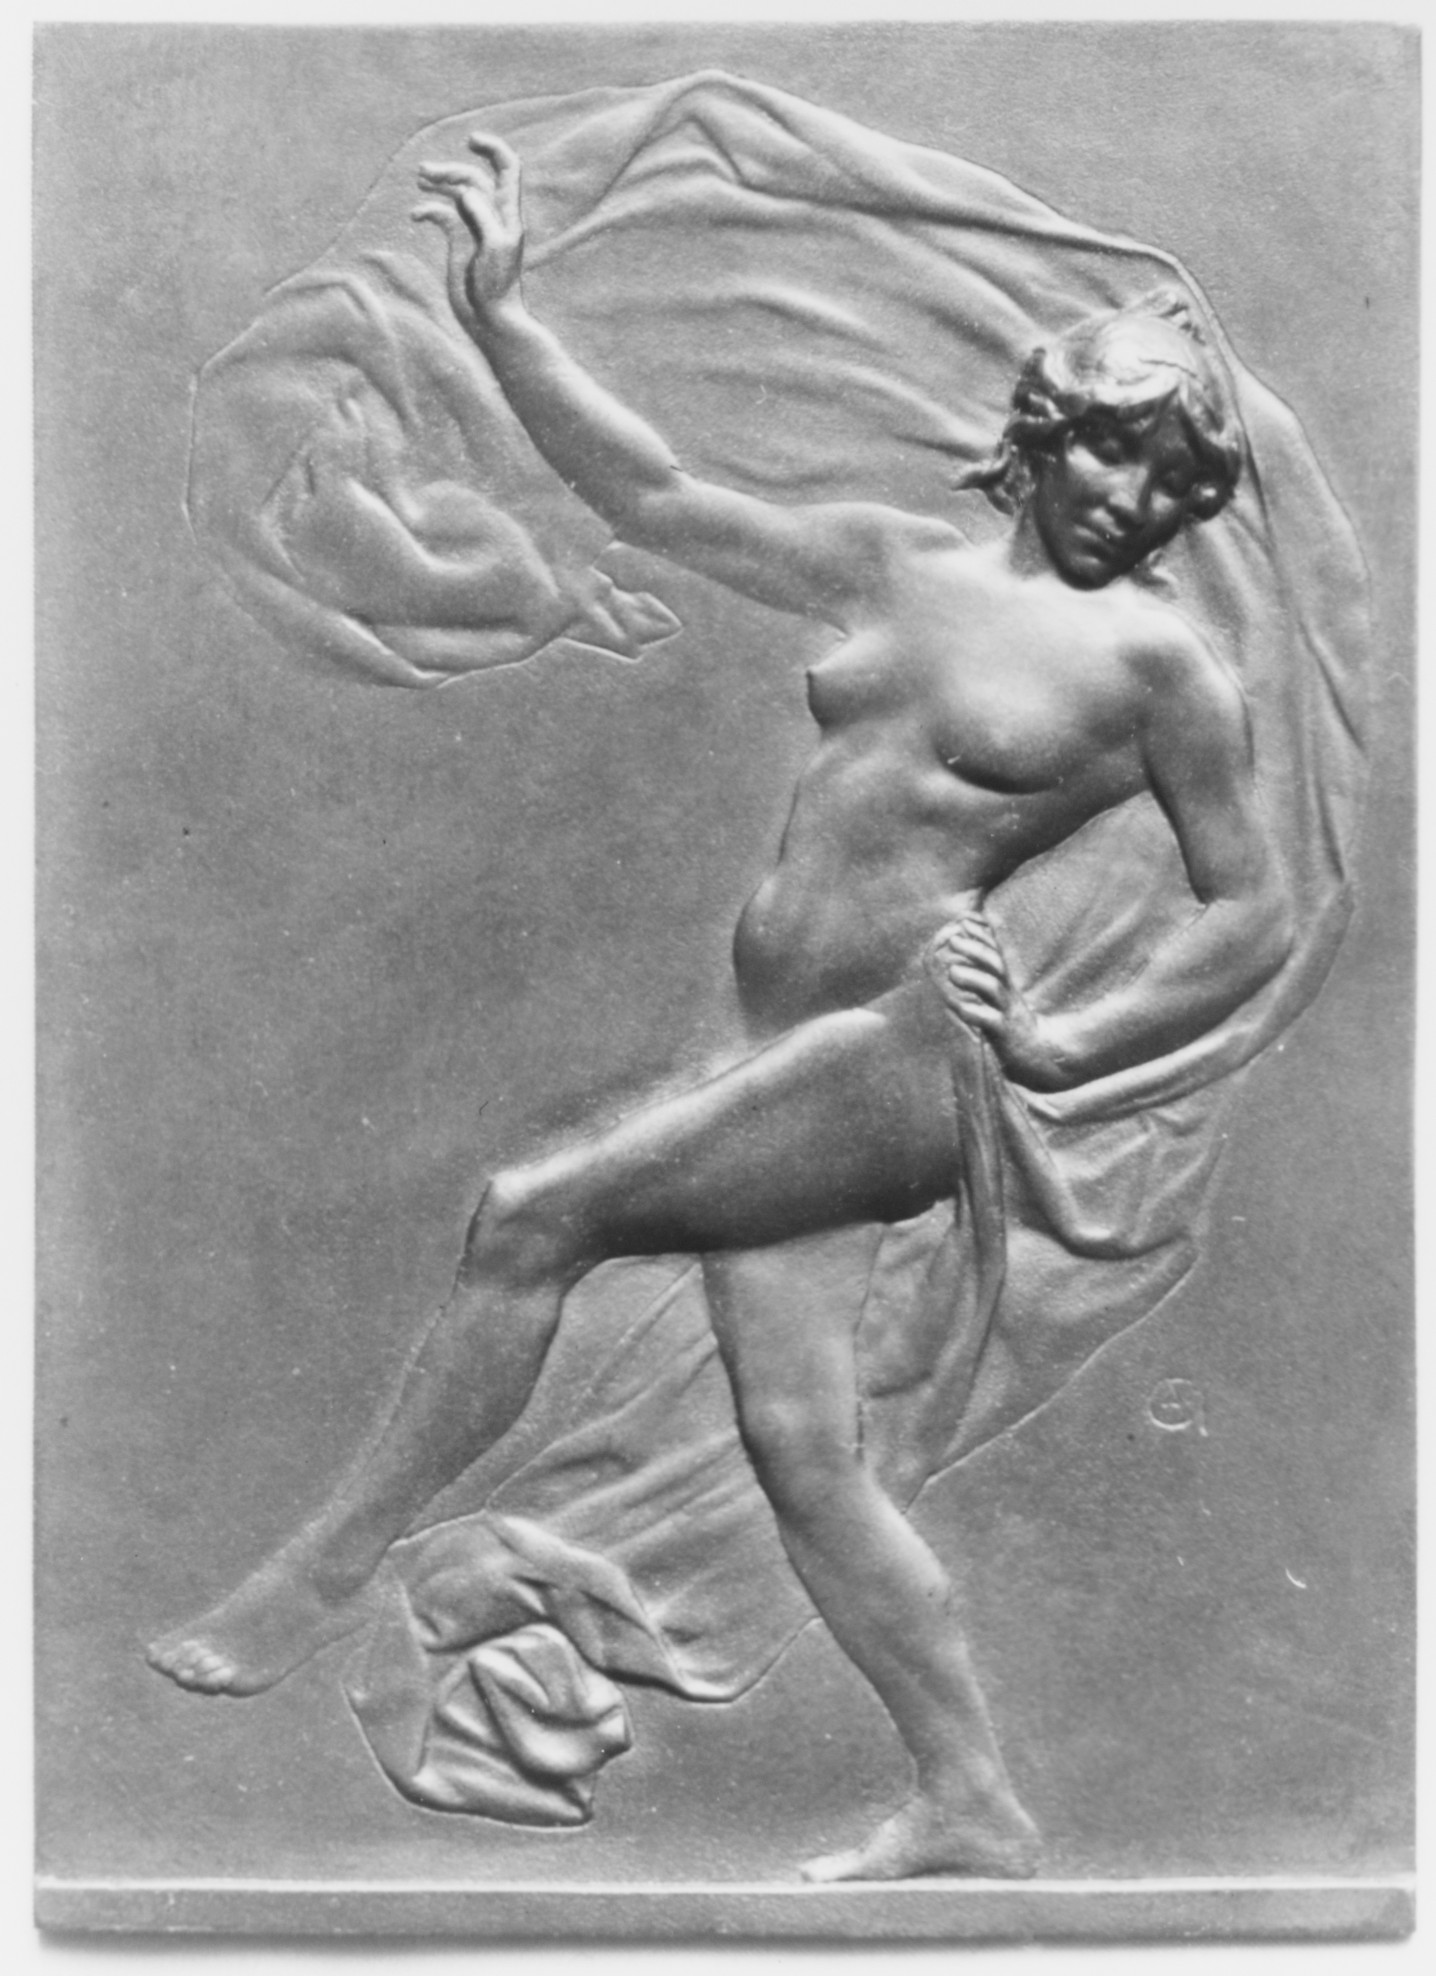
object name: plaquette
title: La Danse (one of a pair)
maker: alexandre-louis-marie charpentier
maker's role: artist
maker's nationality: french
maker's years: 1856-1909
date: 1903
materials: bronze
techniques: casting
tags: female nudes,dancing